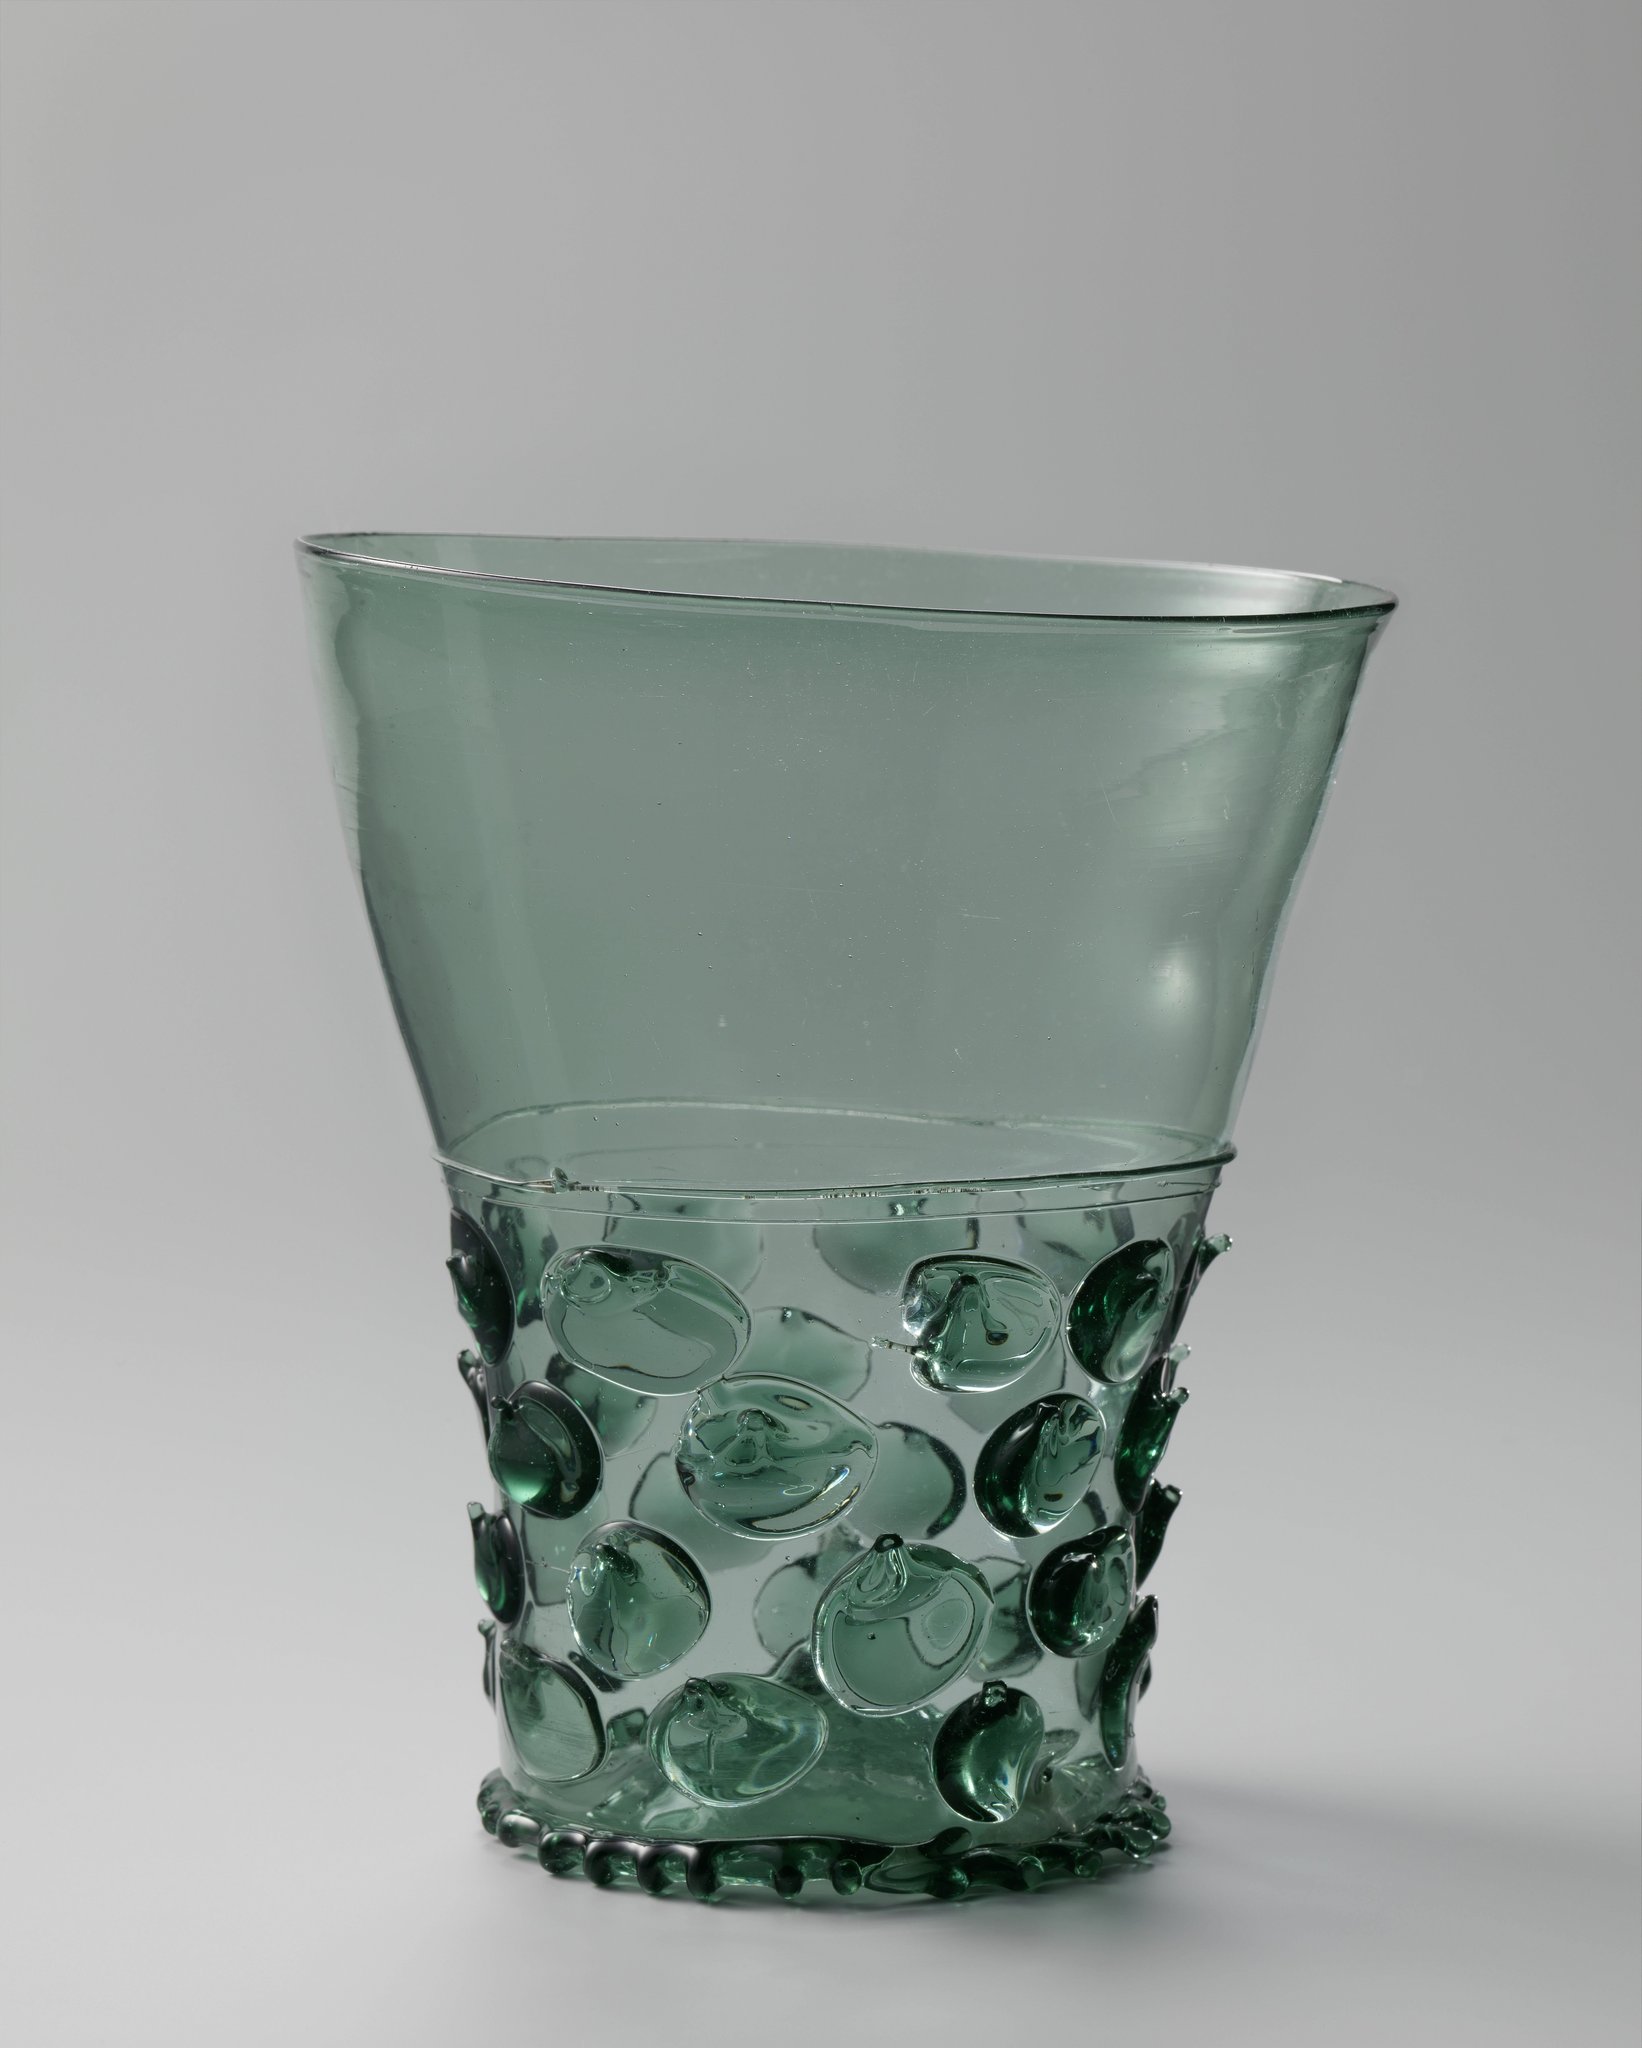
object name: berkenmeier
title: Berkemeyer with four rows of prunts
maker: Anonymous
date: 1575-1625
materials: glass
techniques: glassblowing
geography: germany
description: The Netherlands or Germany, c. 1575–1625 glass